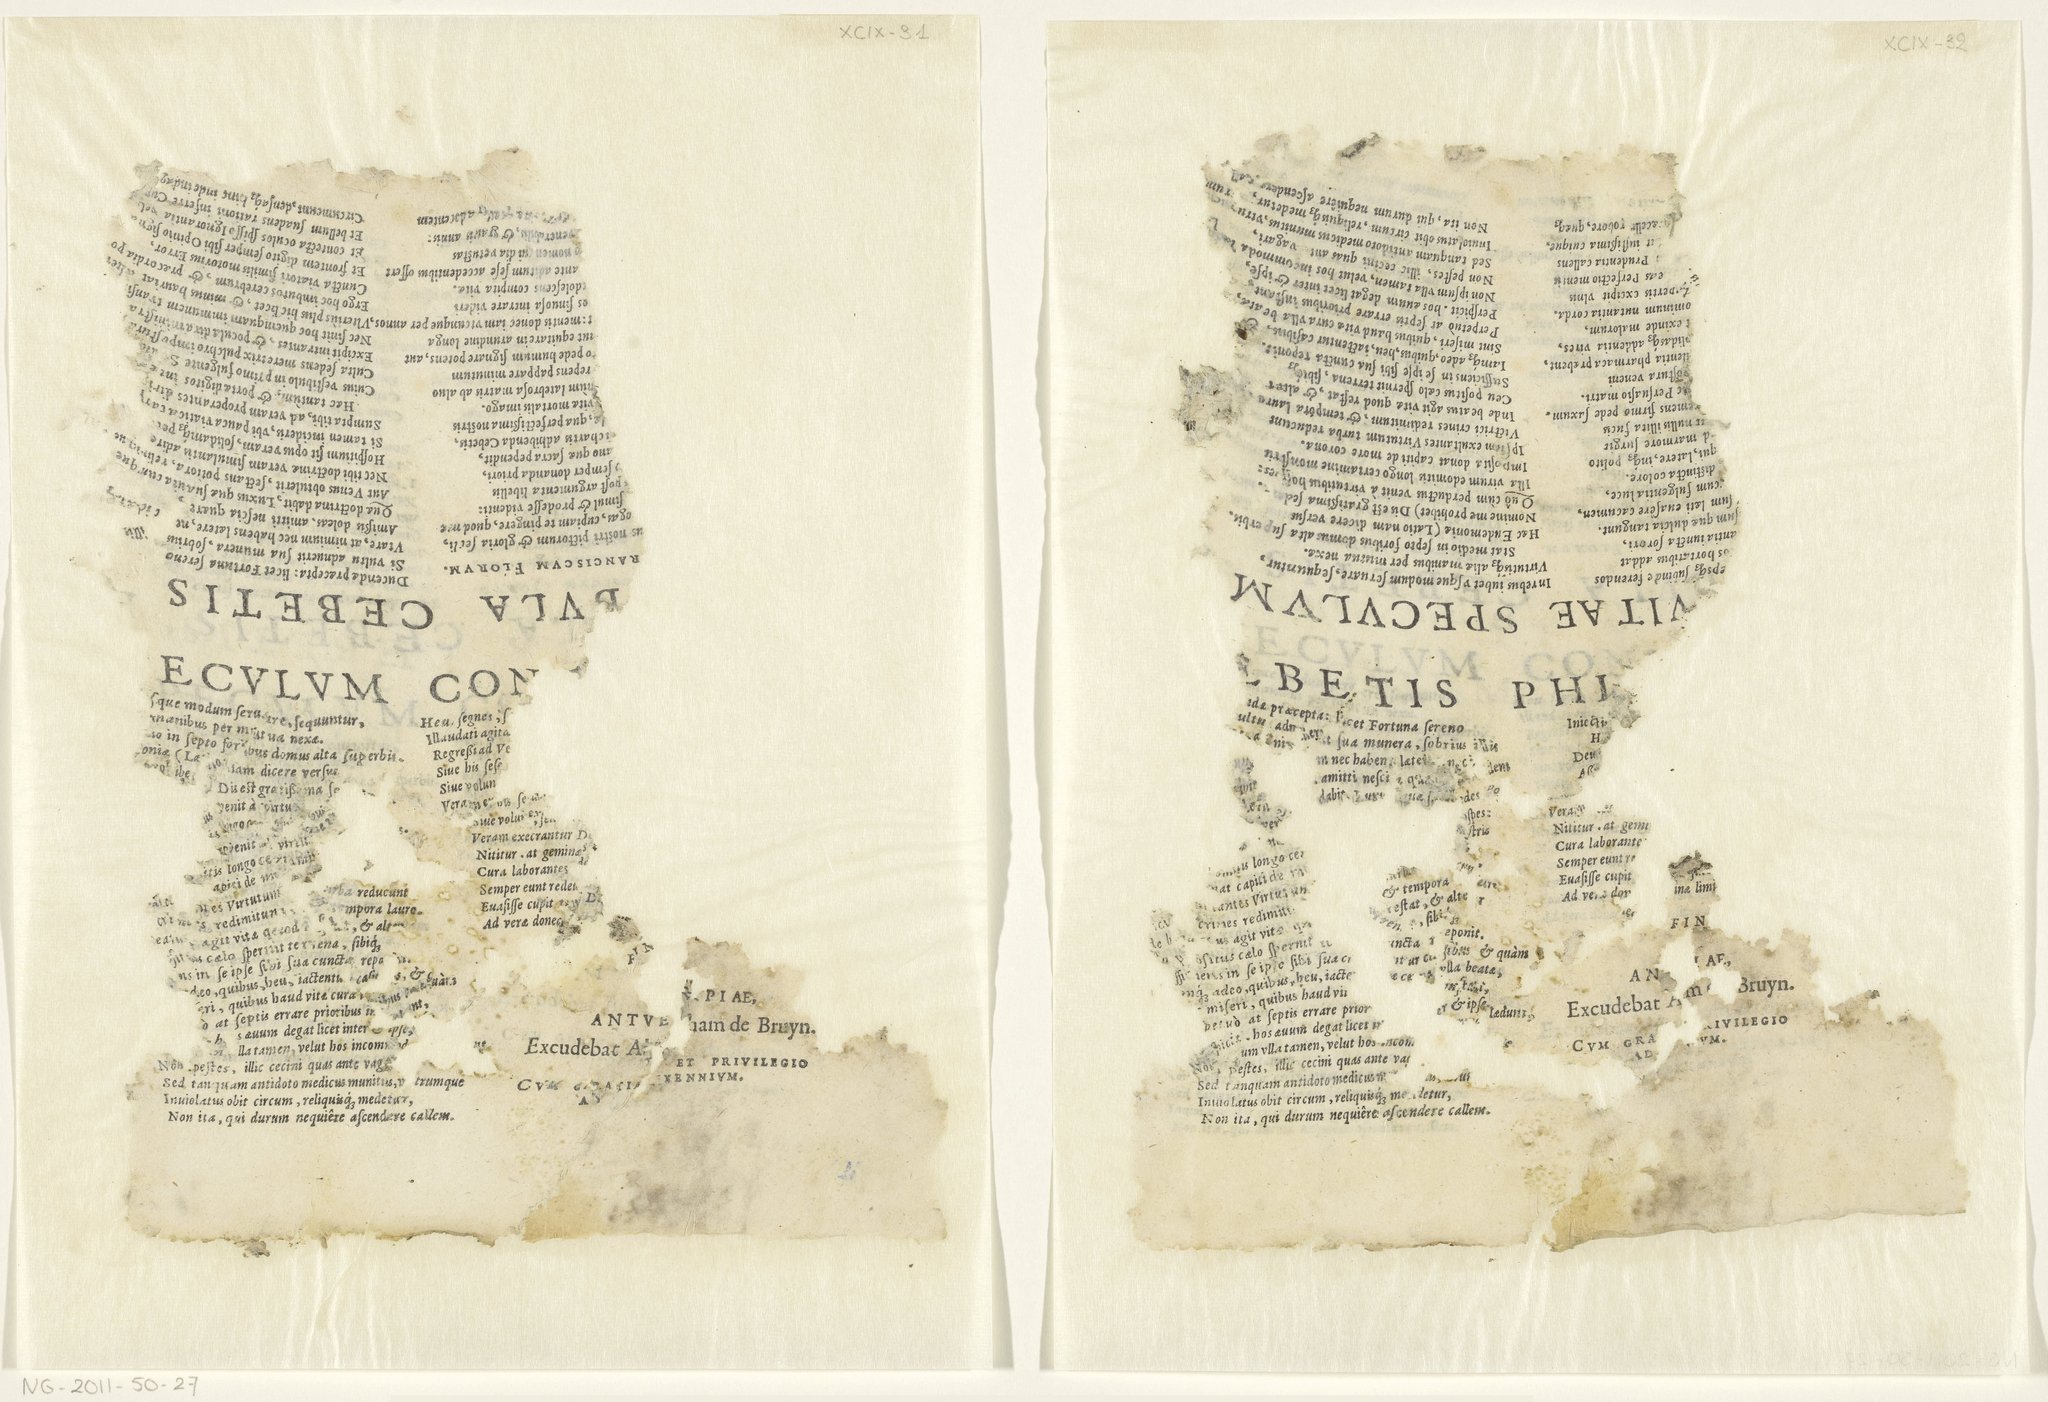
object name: text sheet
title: Twee fragmenten van tekst bij een prent van het tafereel van Cebes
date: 1561-1596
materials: paper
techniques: letterpress printing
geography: antwerp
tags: 'tabula cebetis'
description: Het tekstblad bestond origineel uit twee bladen. De prenten in de Nova Zembla collectie zijn tijdens een expeditie van Willem Barendsz en Jacob van Heemskerk in 1596-1597 noodgedwongen in het winterkamp, het ‘Behouden Huis’, op het eiland achtergelaten. De prenten waren in één of meerdere stapels als handelswaar meegenomen vanuit Amsterdam. Bijna drie eeuwen later, in 1871, keerde de Noor Elling Carlsen terug naar Nova Zembla en vond daar de restanten van het ‘Behouden Huis, inclusief een groot deel van de inventaris. Een deel van de prenten, in de vorm van aaneengekoekte kluiten, werd toen ook teruggevonden. De papierkluiten waren soms op meerdere plekken gebroken. Tussen 1975-1979 zijn de prenten van elkaar gescheiden. Dit leverde in totaal ca. 1000 fragmenten van ca. 400 afdrukken van ca. 150 verschillende prenten op. Voor zover mogelijk zijn de fragmenten samengevoegd en zijn de prenten gereconstrueerd.